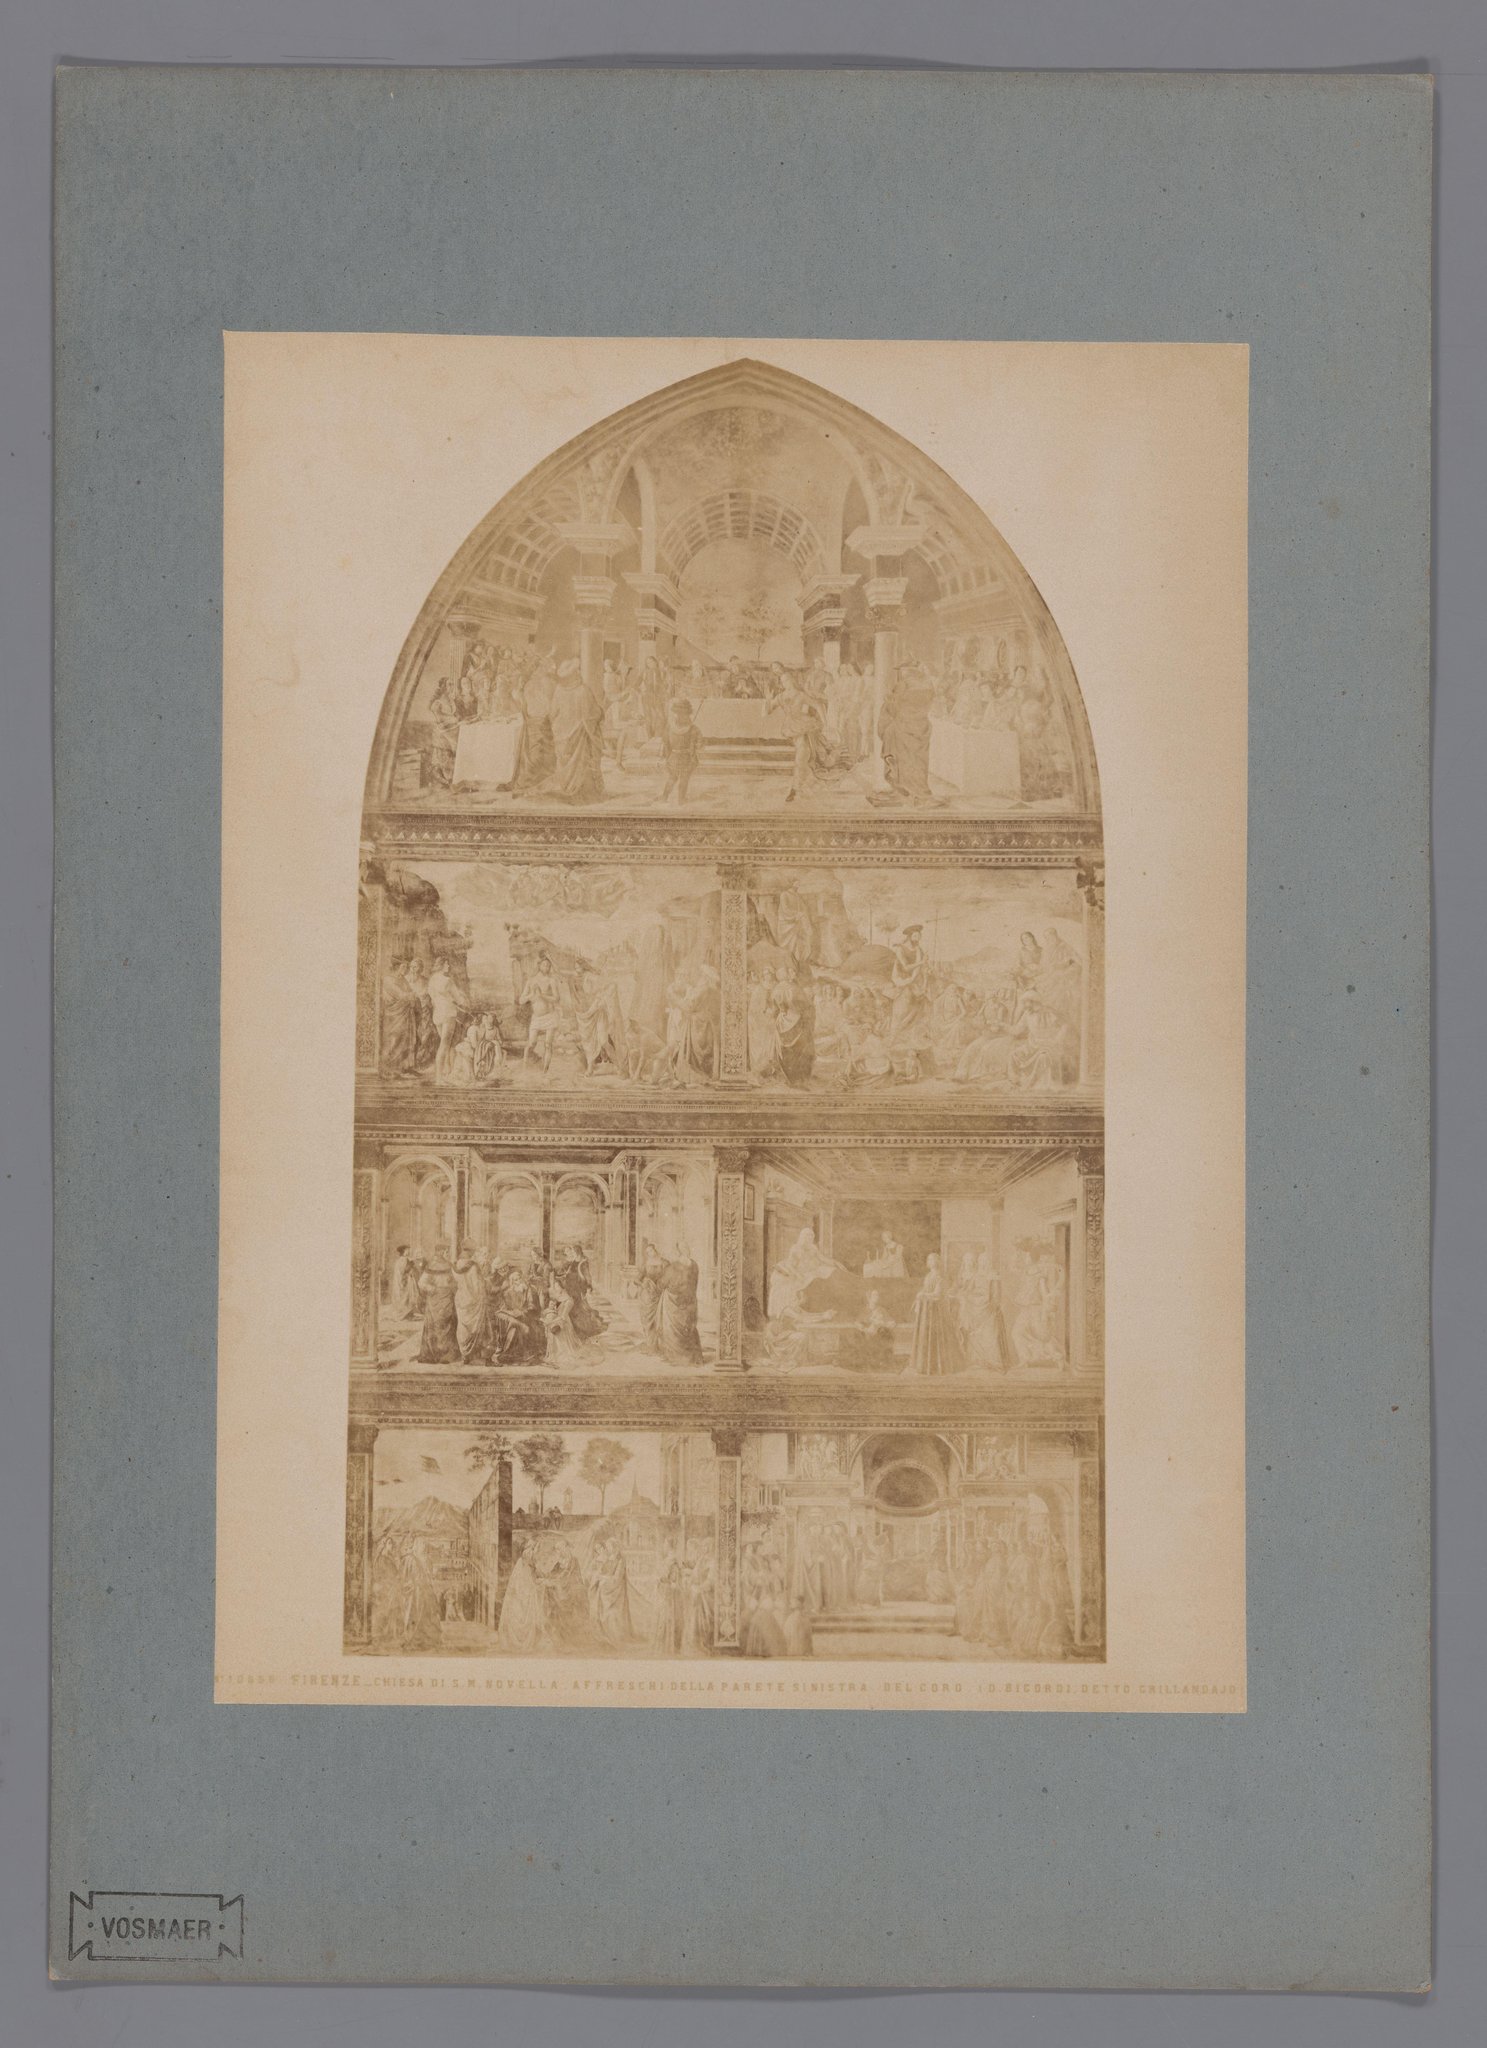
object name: photograph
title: Fotoreproductie van fresco met scènes uit de levens van Johannes de Doper en Maria naar Domenico Ghirlandaio in de Santa Maria Novella te Florence, Italië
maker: domenico ghirlandaio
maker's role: draughtsman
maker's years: 1449-1494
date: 1857-1900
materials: cardboard, paper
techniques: albumen print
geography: florence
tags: picture, painting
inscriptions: number: ‘No. 10856’, collector's mark: ‘VOSMAER’